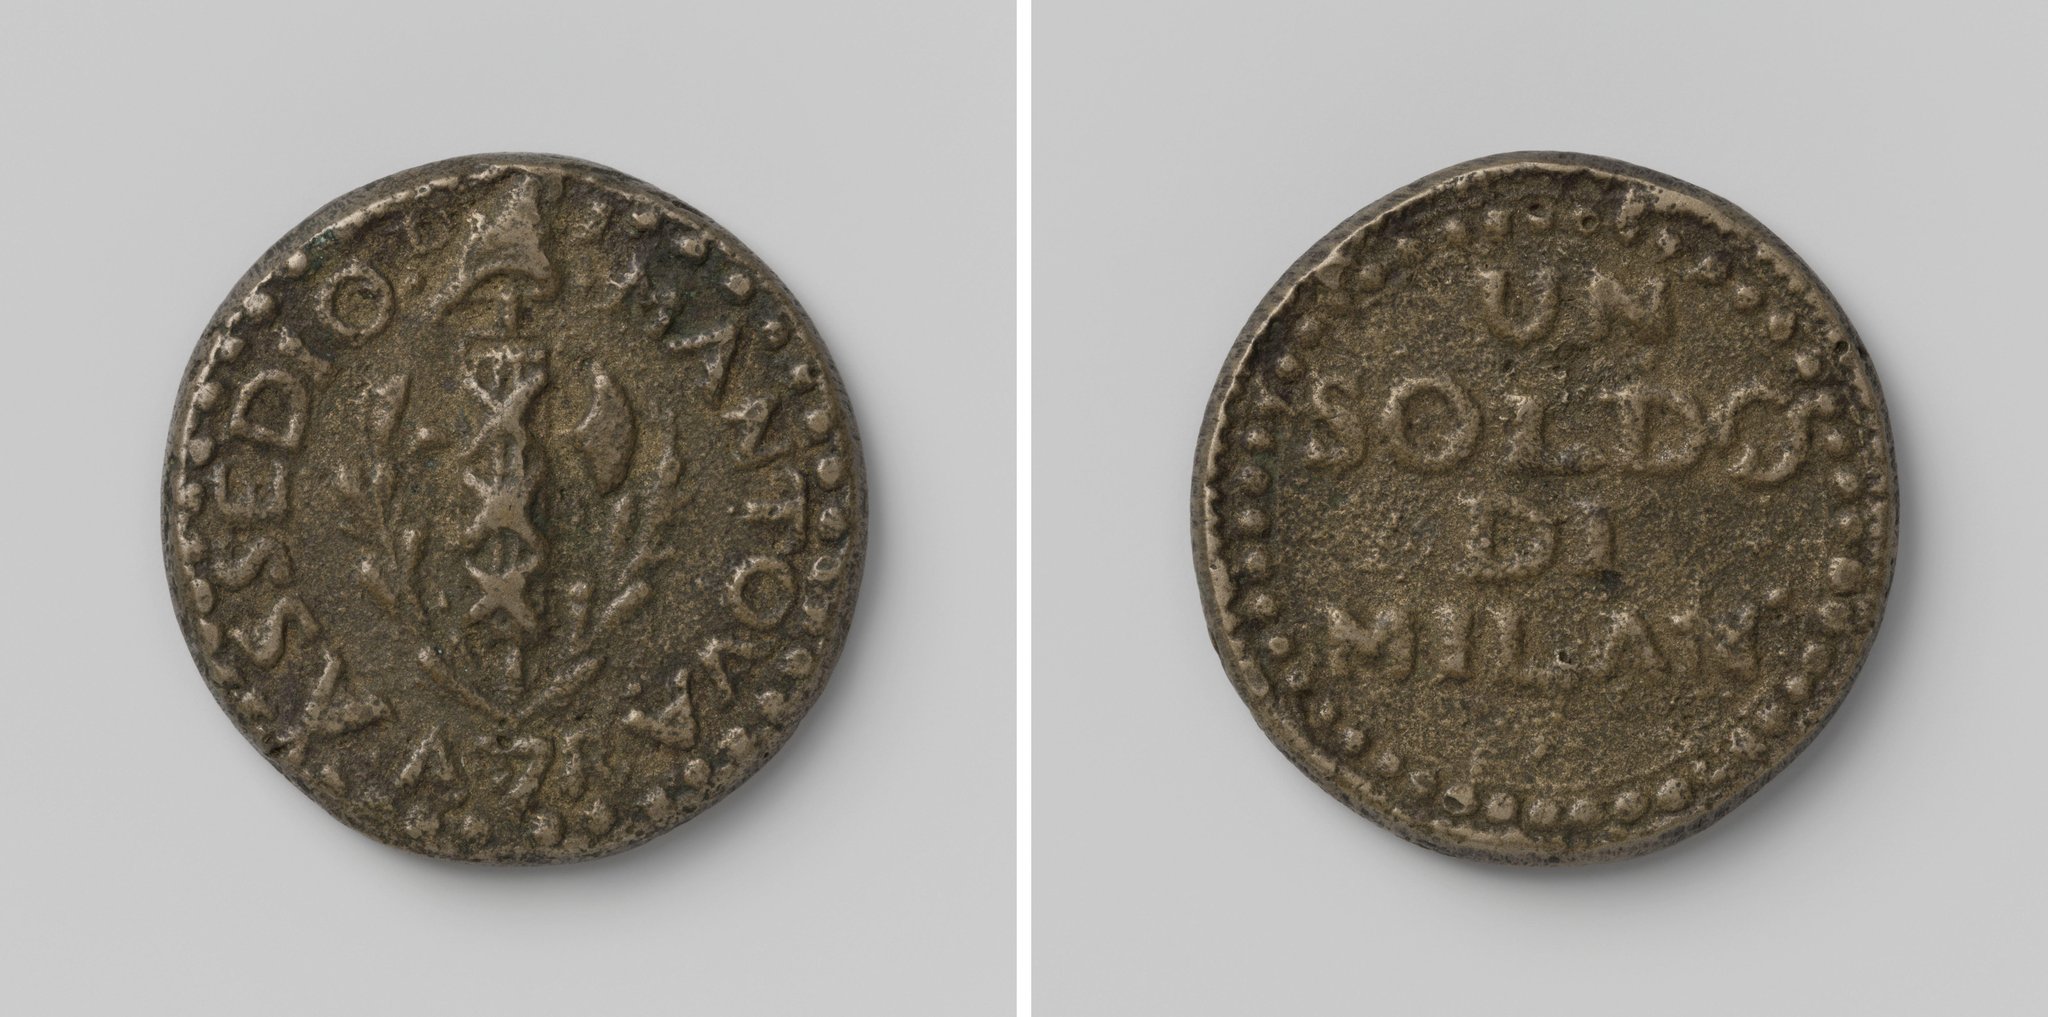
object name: soldo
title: Soldo, noodmunt uit Mantua, geslagen tijdens het beleg door de keizerlijken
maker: Anonymous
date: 1799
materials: copper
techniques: striking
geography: mantua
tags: mantua, tweede coalitie-oorlog, franse revolutie, beleg van mantua (1799)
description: Voorzijde: roedebundel met bijl, bekroond met vrijheidsmuts binnen krans van lauwertakken en omschrift. Keerzijde: waardeaanduiding